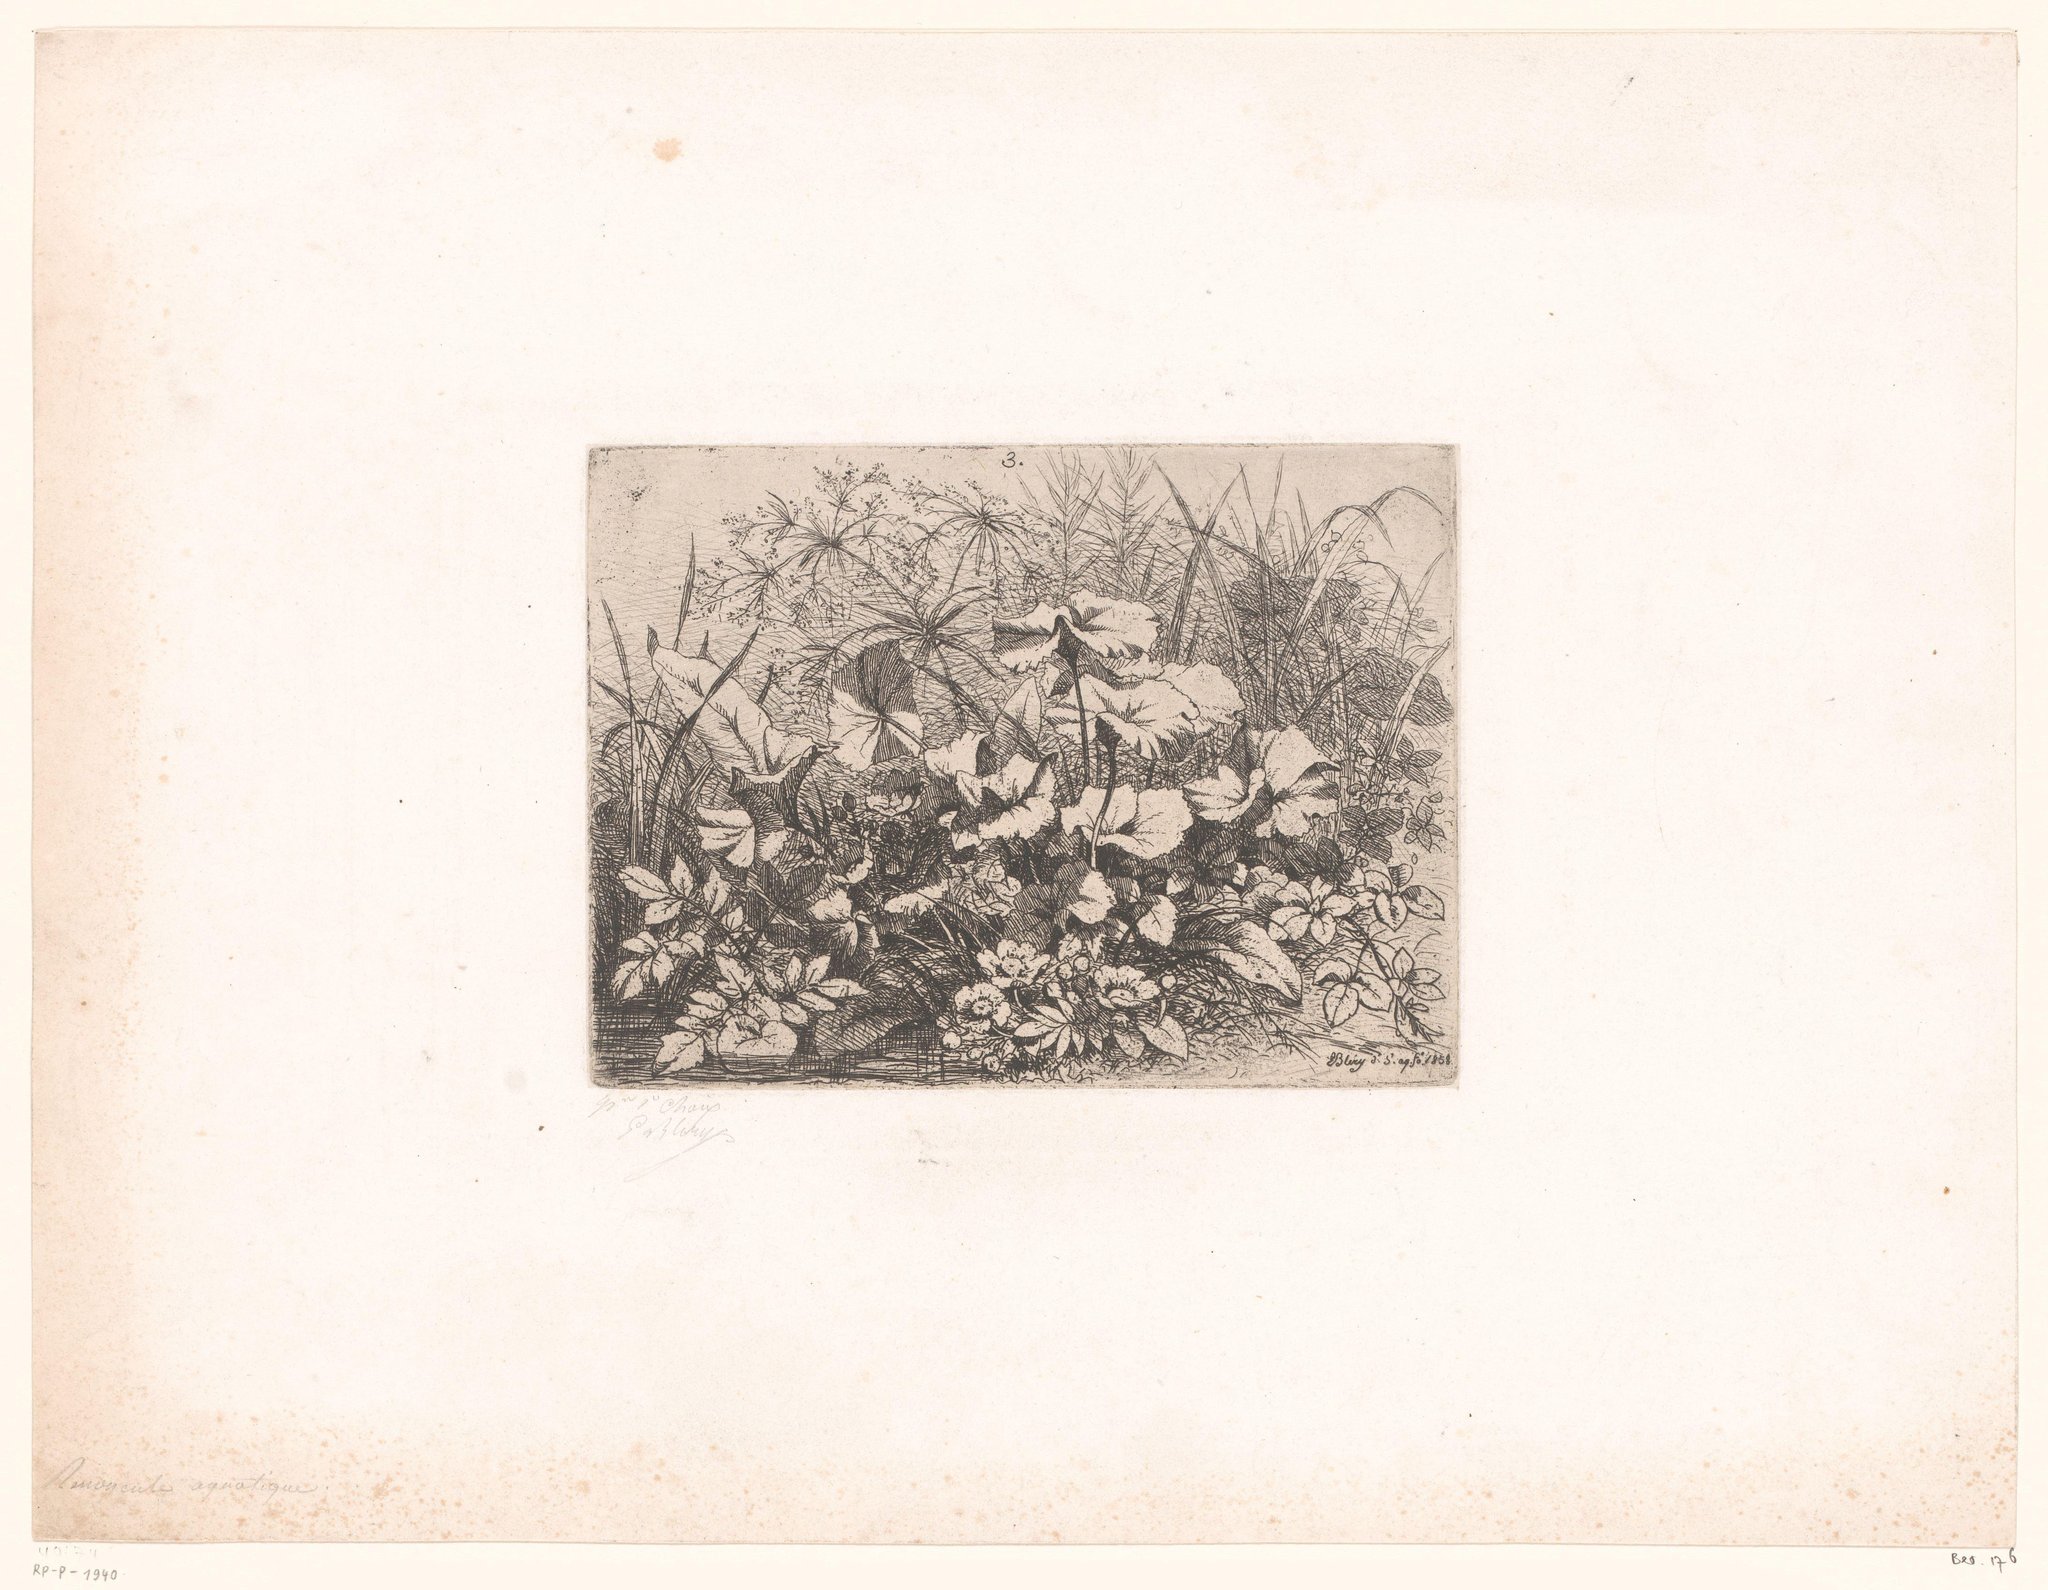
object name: print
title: Douze motifs de plantes, Ex F.esm par Eug. Bléry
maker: eugène bléry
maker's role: print maker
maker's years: 1805-1887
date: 1858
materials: paper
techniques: aquatint, drypoint, engraving, etching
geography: france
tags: flowers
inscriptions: collector's mark: Lugt 2760, collector's mark: Lugt 2166